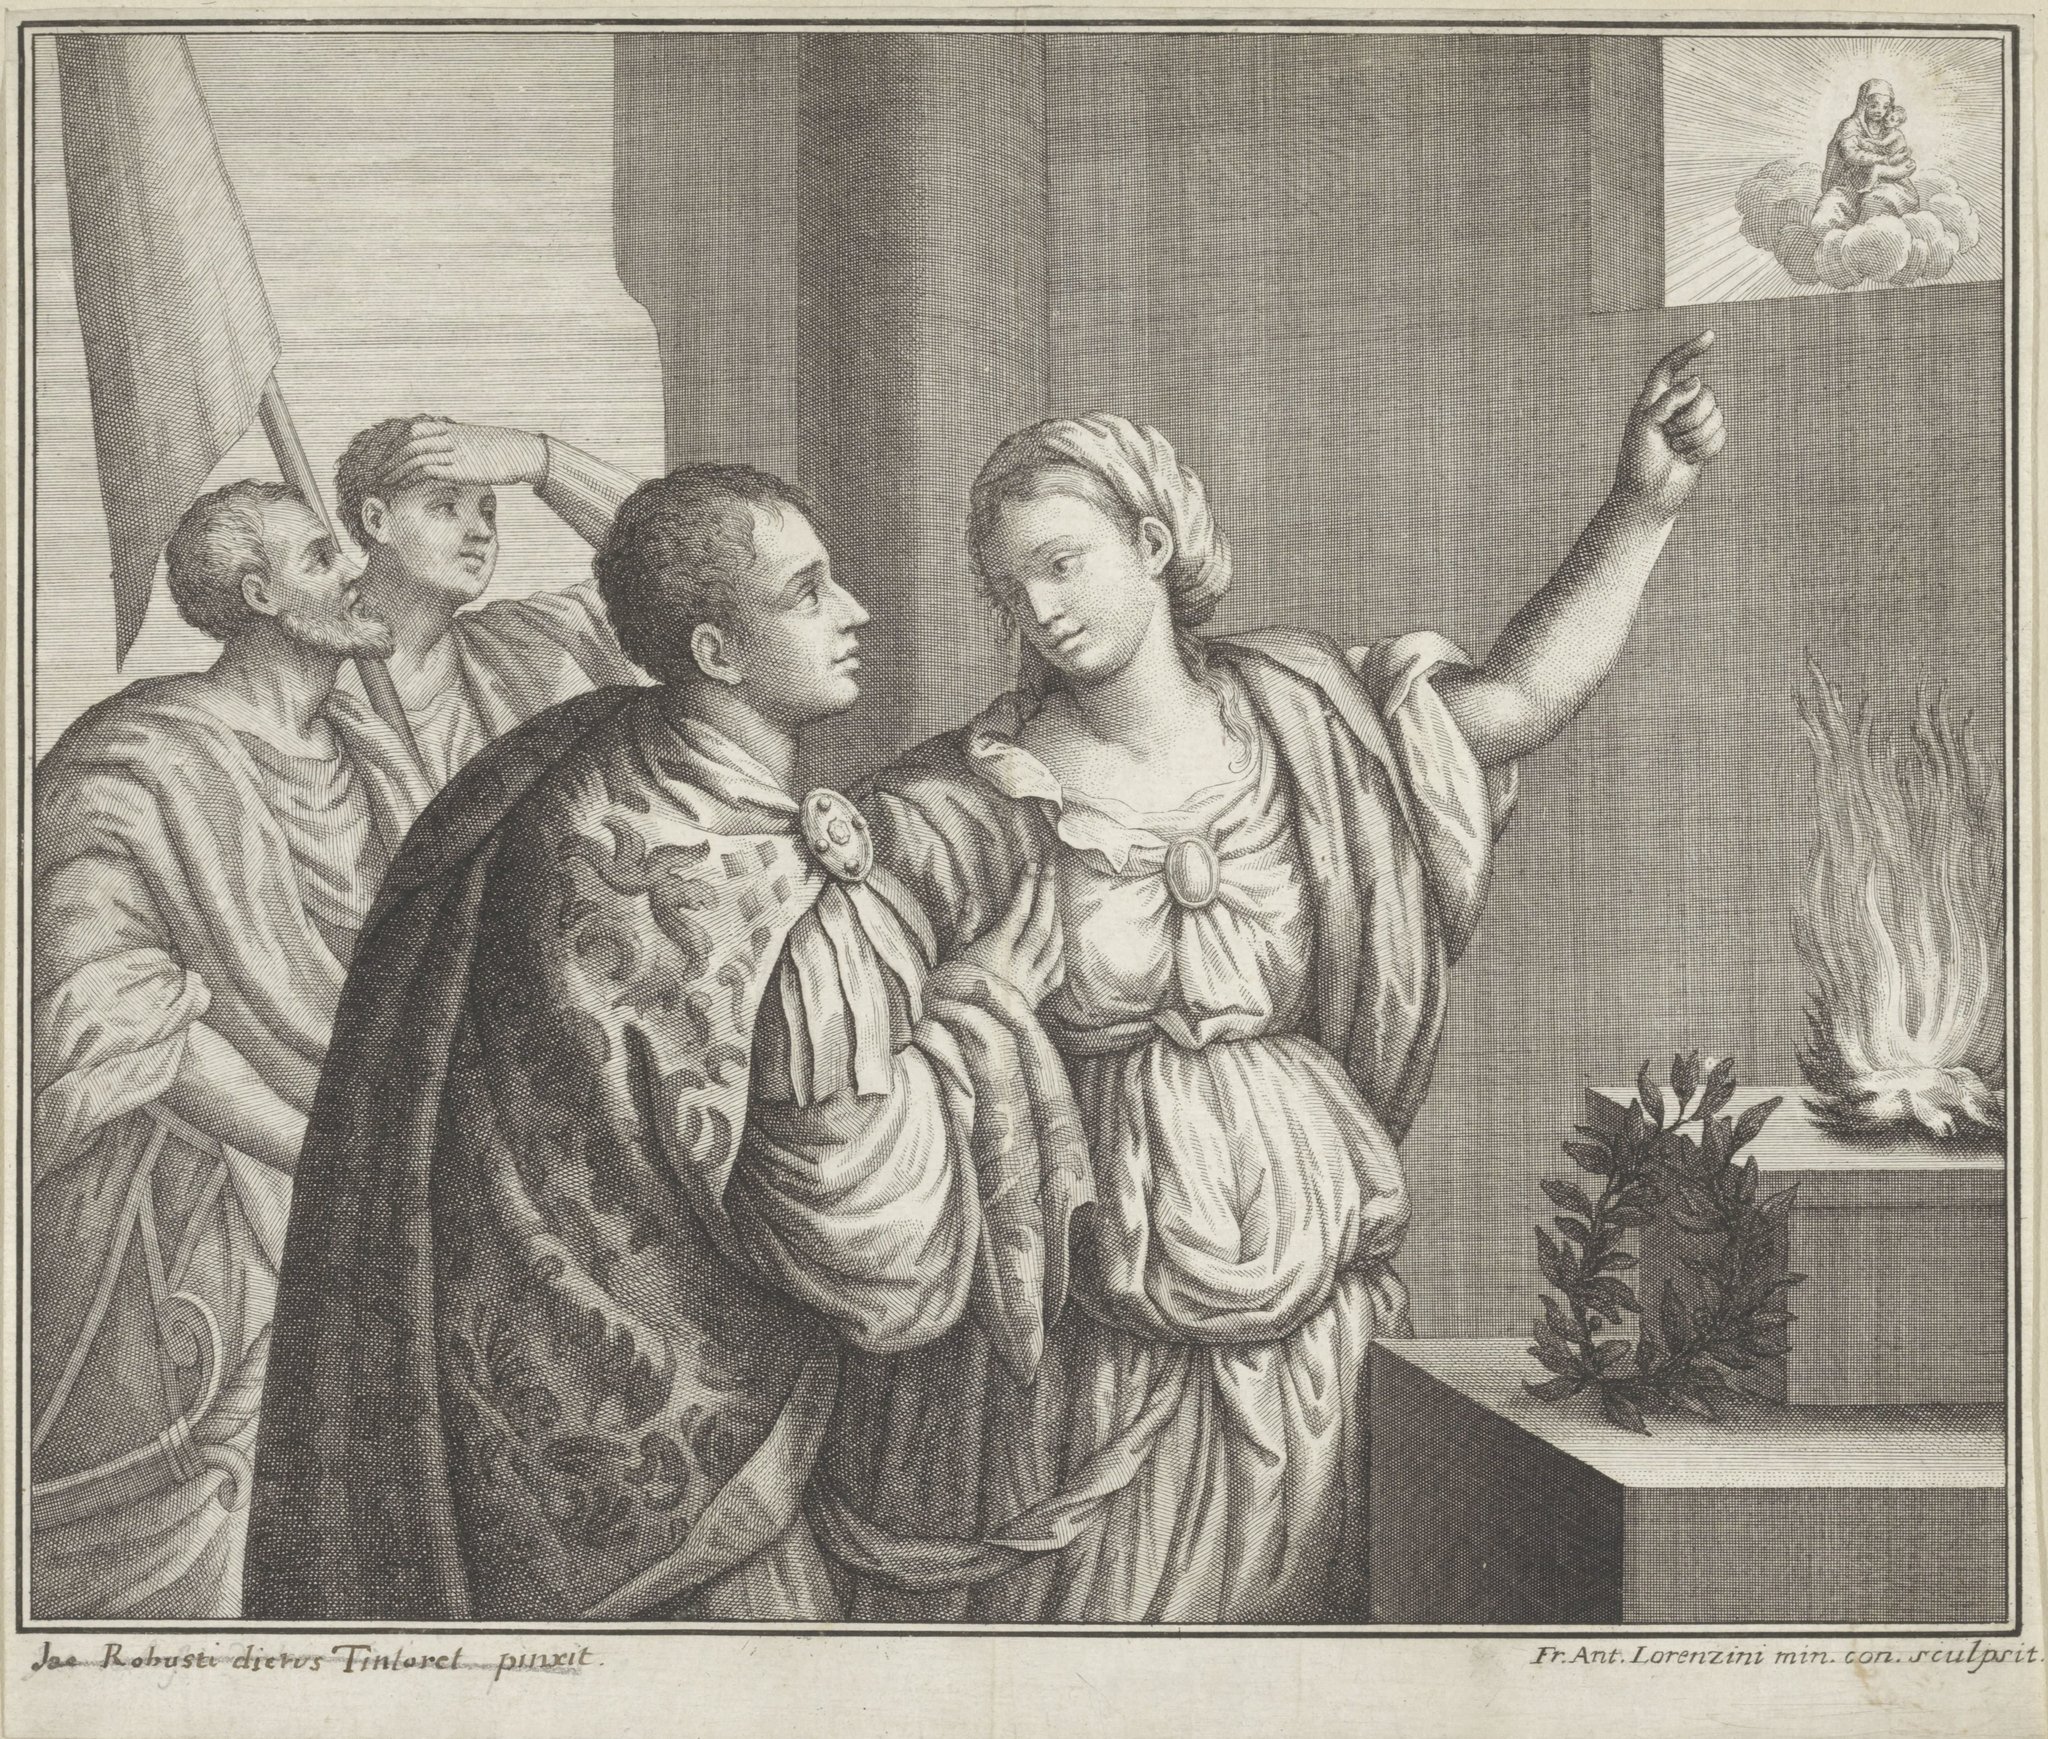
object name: print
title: Vrouw wijst man bij altaar op Maria met Kind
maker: giovanni antonio lorenzini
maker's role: print maker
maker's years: 1665-1740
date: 1675-1740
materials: paper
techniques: etching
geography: italy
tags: madonna: i.e. mary with the christ-child, the tiburtine sibyl and augustus: the sibyl reveals to the emperor a vision of the madonna in heaven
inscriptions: inscription: ‘Jac Robusti di[...]us Tintoret pinxit’, collector's mark: Lugt 240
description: Een vrouw bij een altaar wijst een man in een mooie mantel door een venster op Maria met Kind die aan de hemel zijn verschenen. Op de achtergrond twee mannen. Mogelijk Keizer Augustus en de Tiburtijnse Sibille.